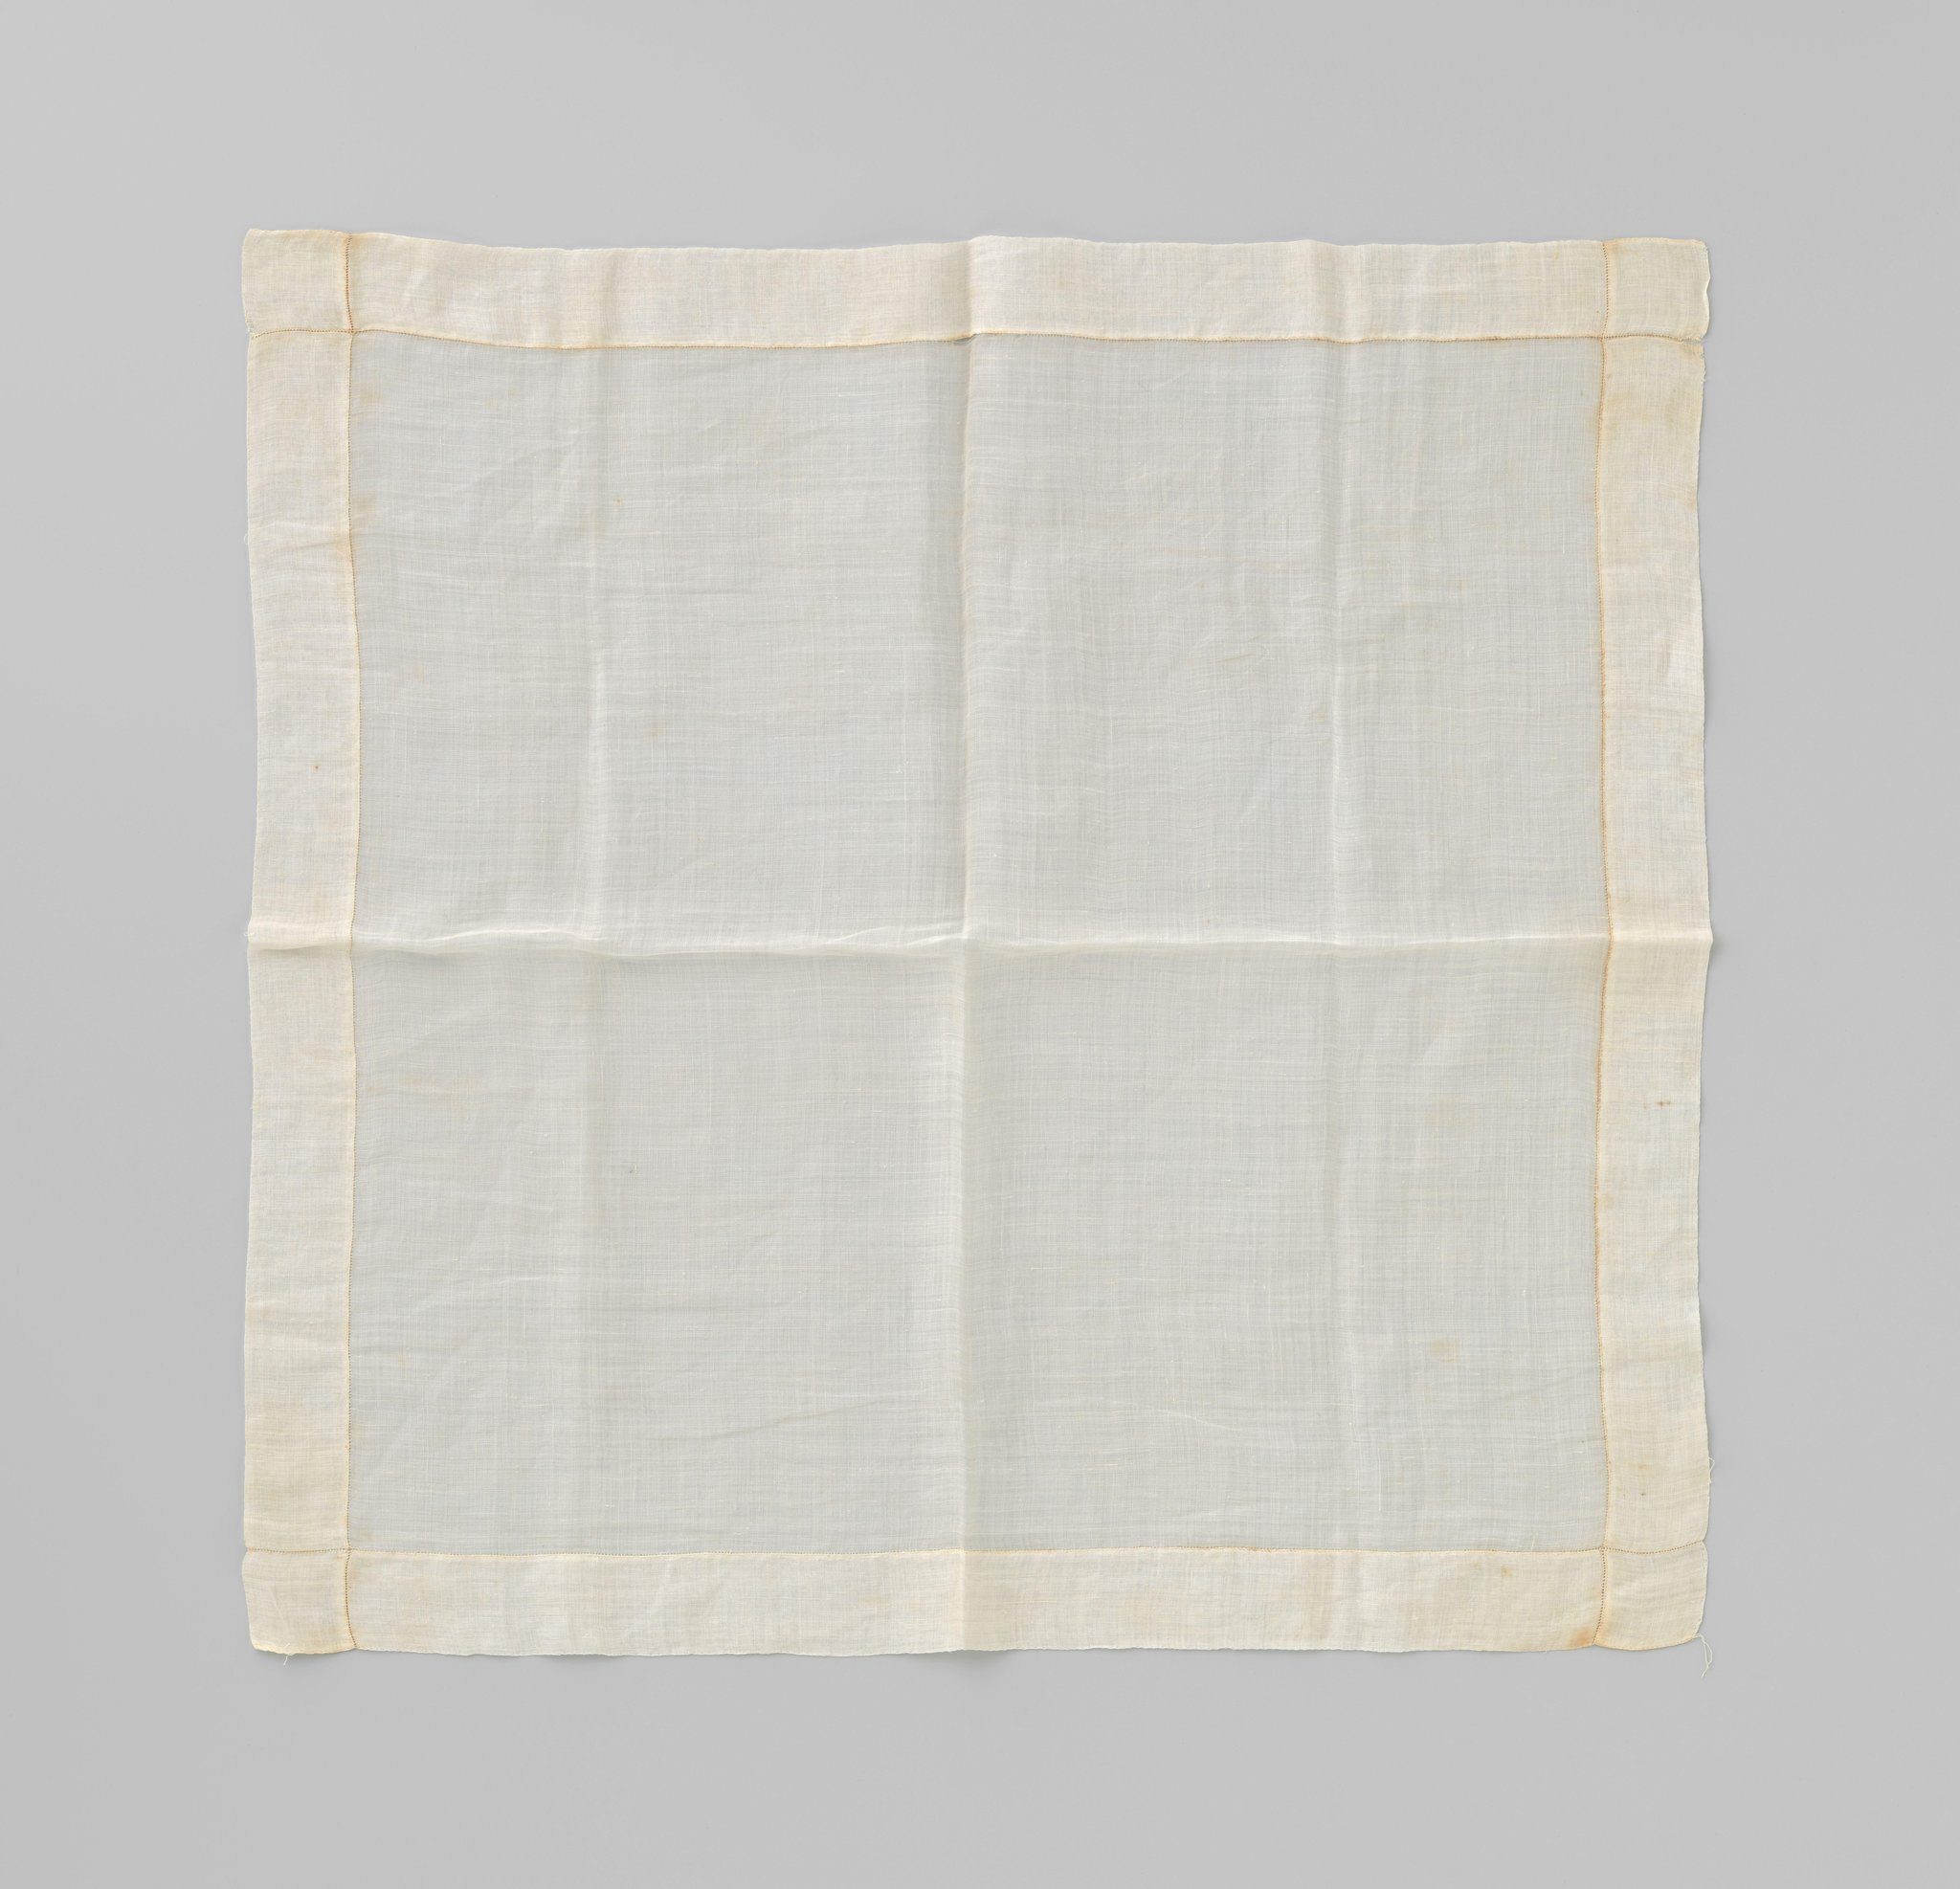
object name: handkerchief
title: Vierkante zakdoek van batist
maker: Anonymous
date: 1850-1940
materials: textile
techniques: weave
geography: europe